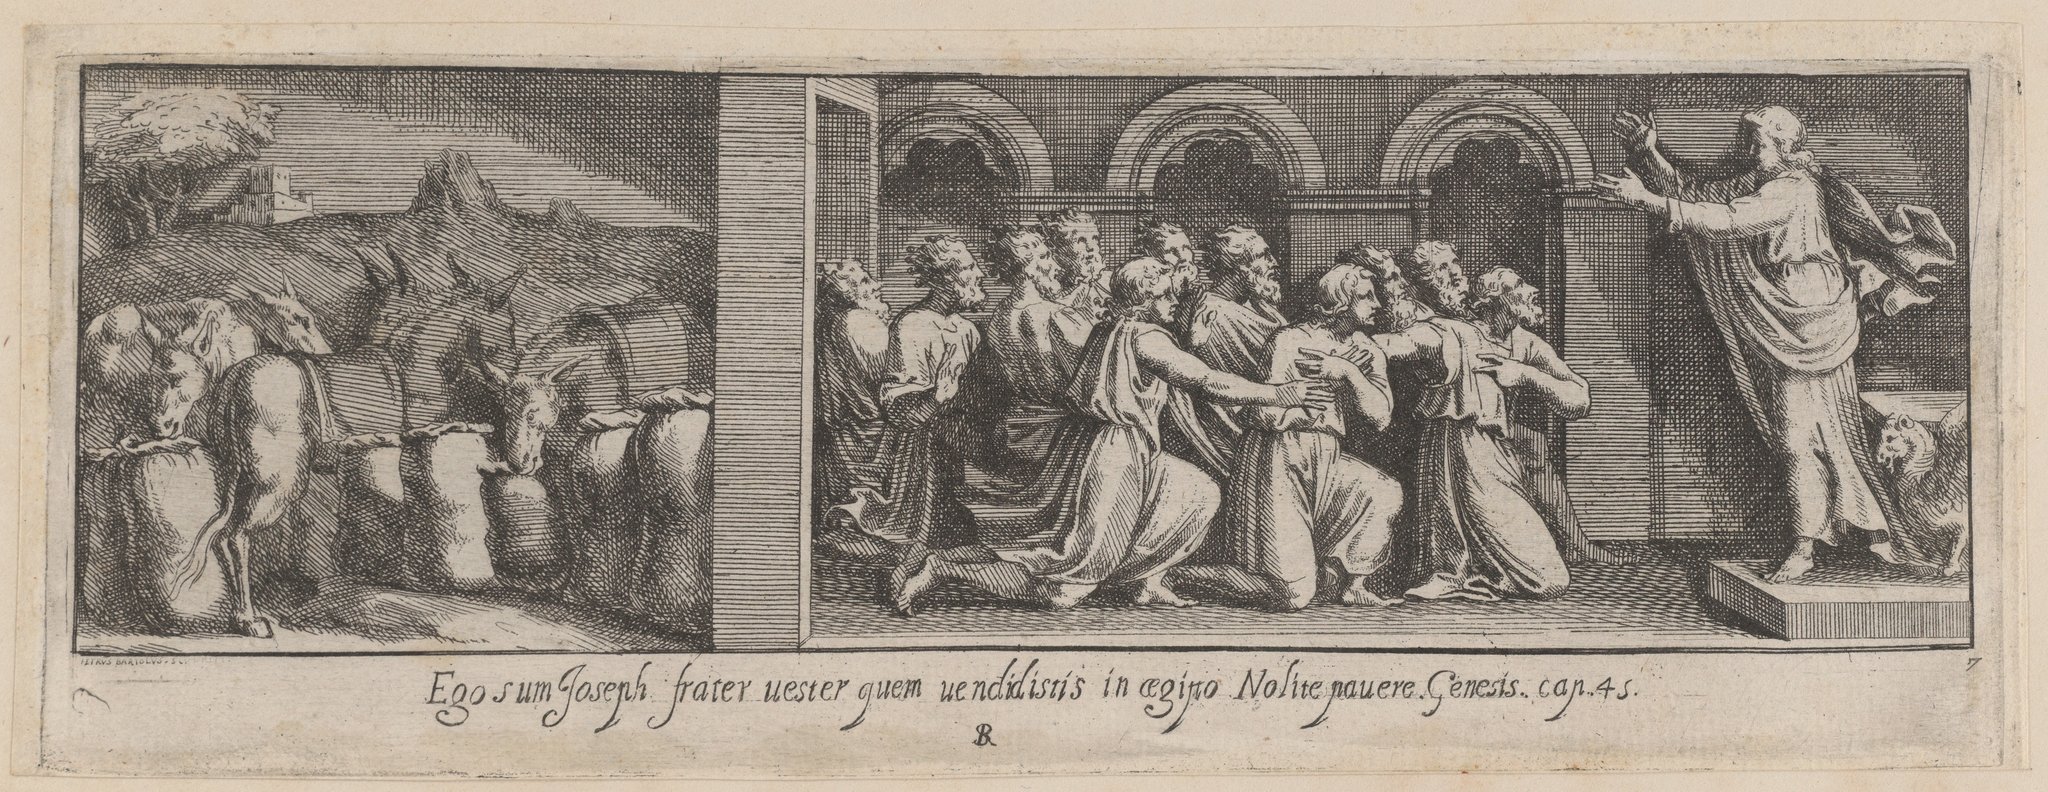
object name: print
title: Plate 7: Joseph Making Himself Known to his Brothers, from Genesis 45, after a lost fresco in the basamento of Bay 7 of the Vatican Loggia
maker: pietro santi bartoli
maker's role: artist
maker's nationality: italian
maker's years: 1615-1700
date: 1650-1677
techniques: etching